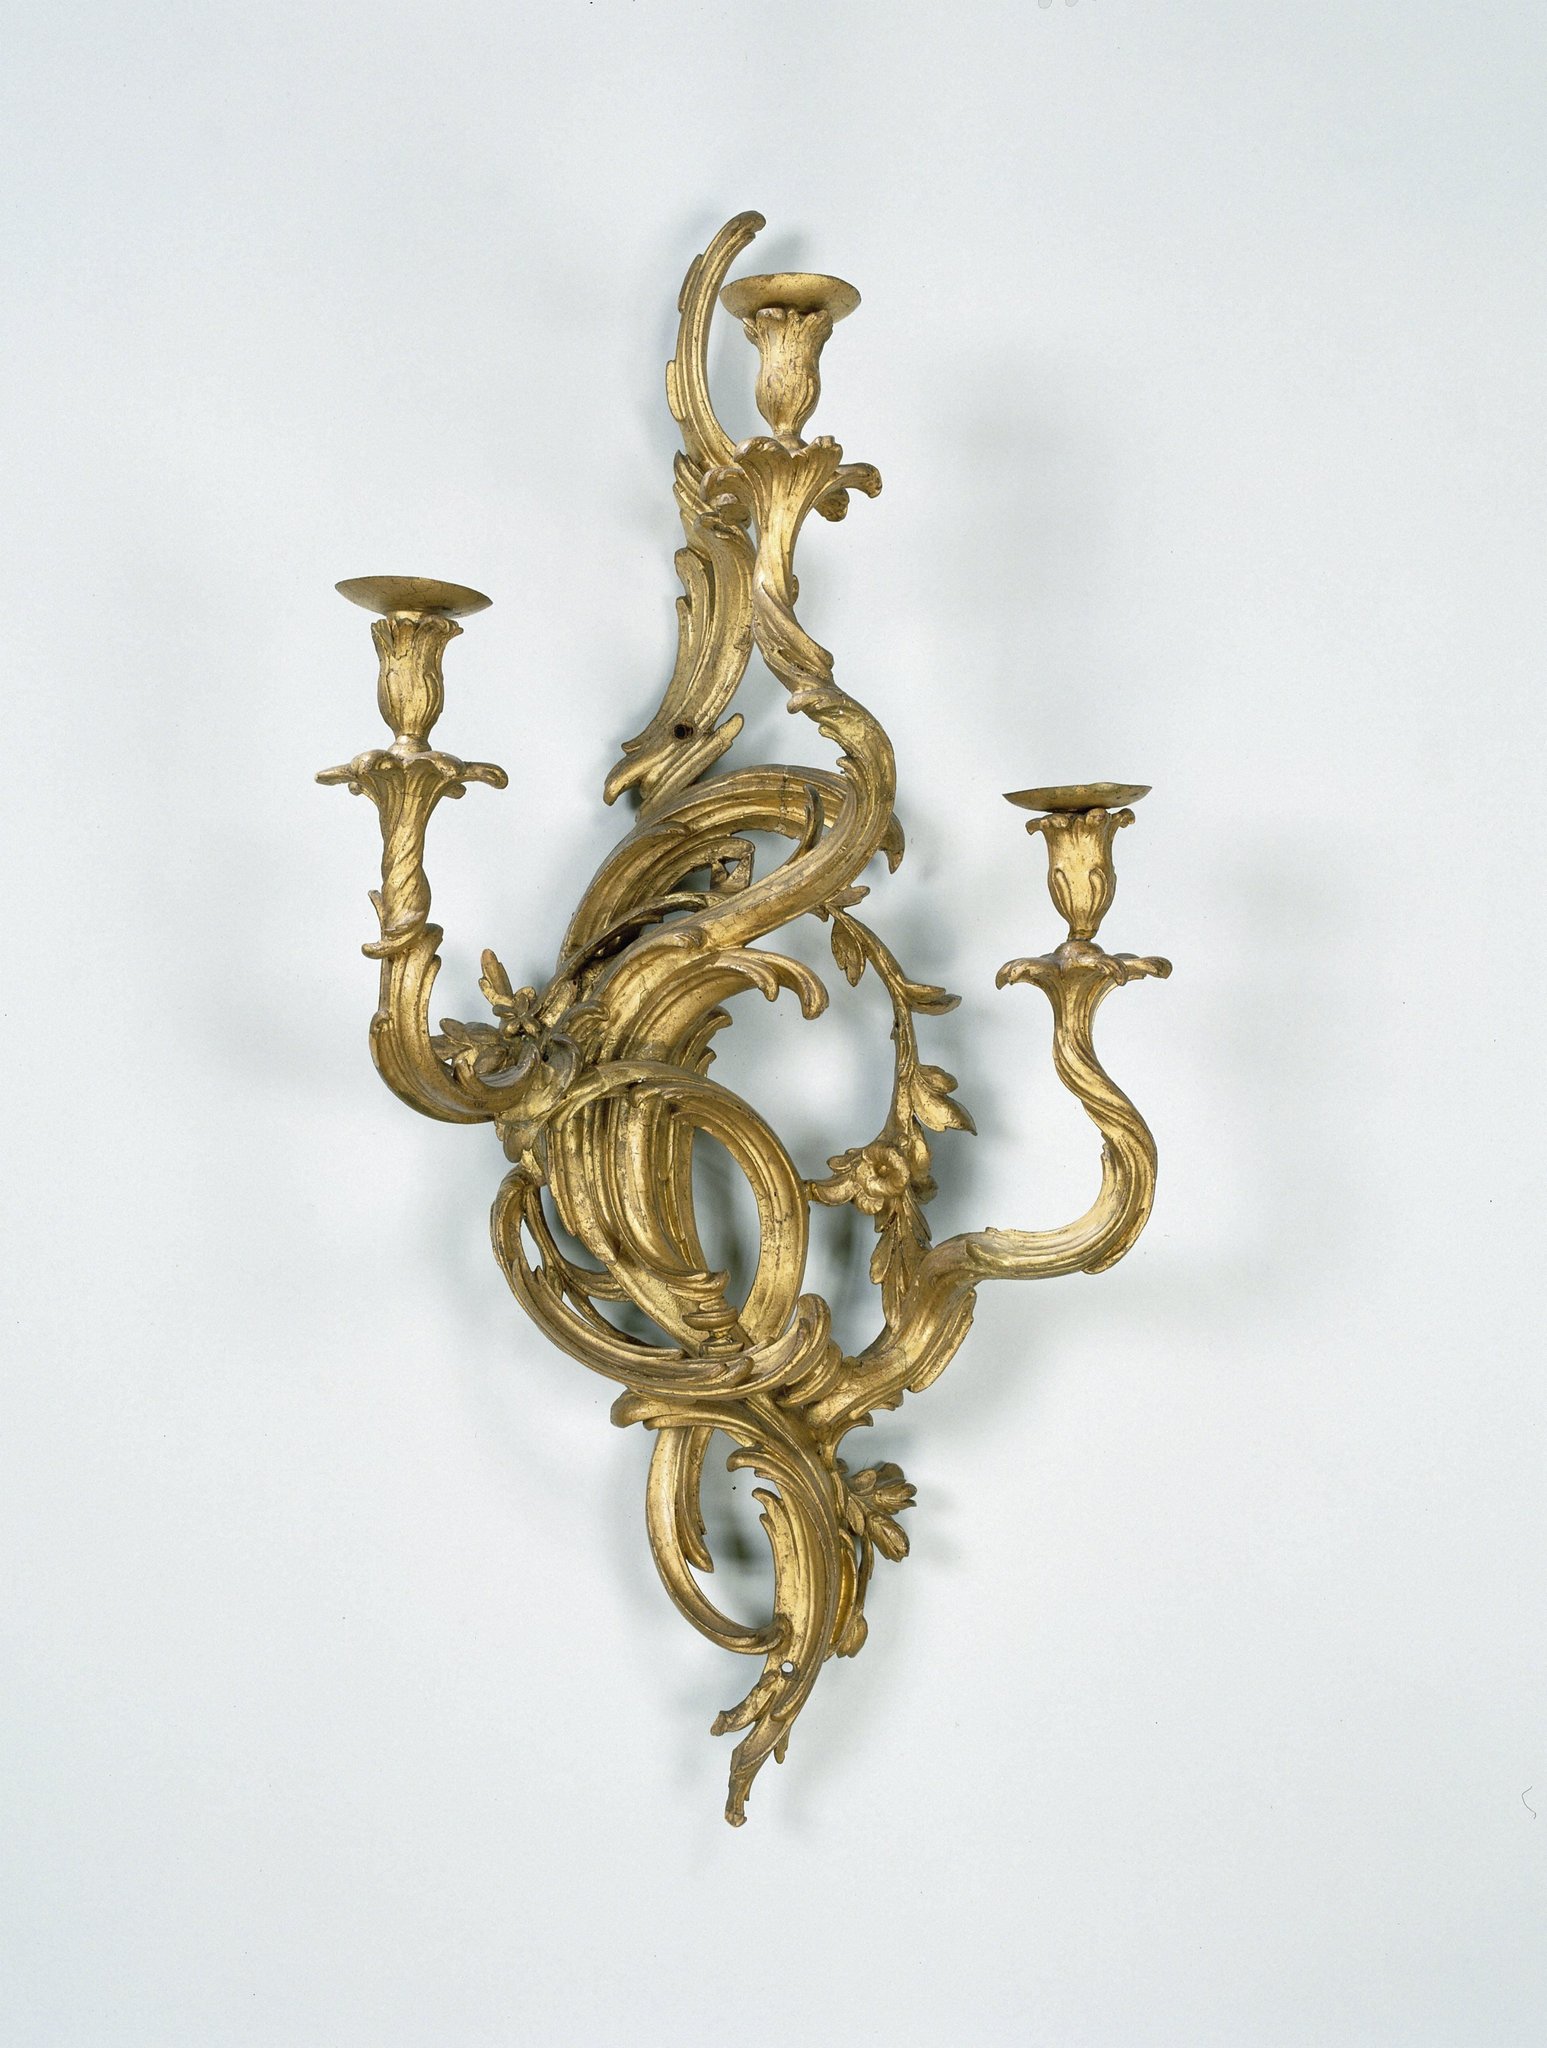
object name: furniture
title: Wandarm van verguld lindehout met drie kaarsenhouders en decoratie van asymmetrisch gebeeldhouwd acanthusbladwerk met bloemen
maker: Anonymous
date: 1755-1770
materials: wood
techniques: cutting, gilding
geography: netherlands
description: Mirror cabinet. Oak, veneered with burr walnut, tulipwood and other woods, inlaid with mirrors painted on the back. Silver mounts. Amsterdam (?), the mirrors probably China, the mounts by Dirk Froger. Two wall-lights. Limewood, gilded. Netherlands, c. 1750. The wall-lights have indentations at the back, showing that they were originally attached to profiles on a panelled wall.